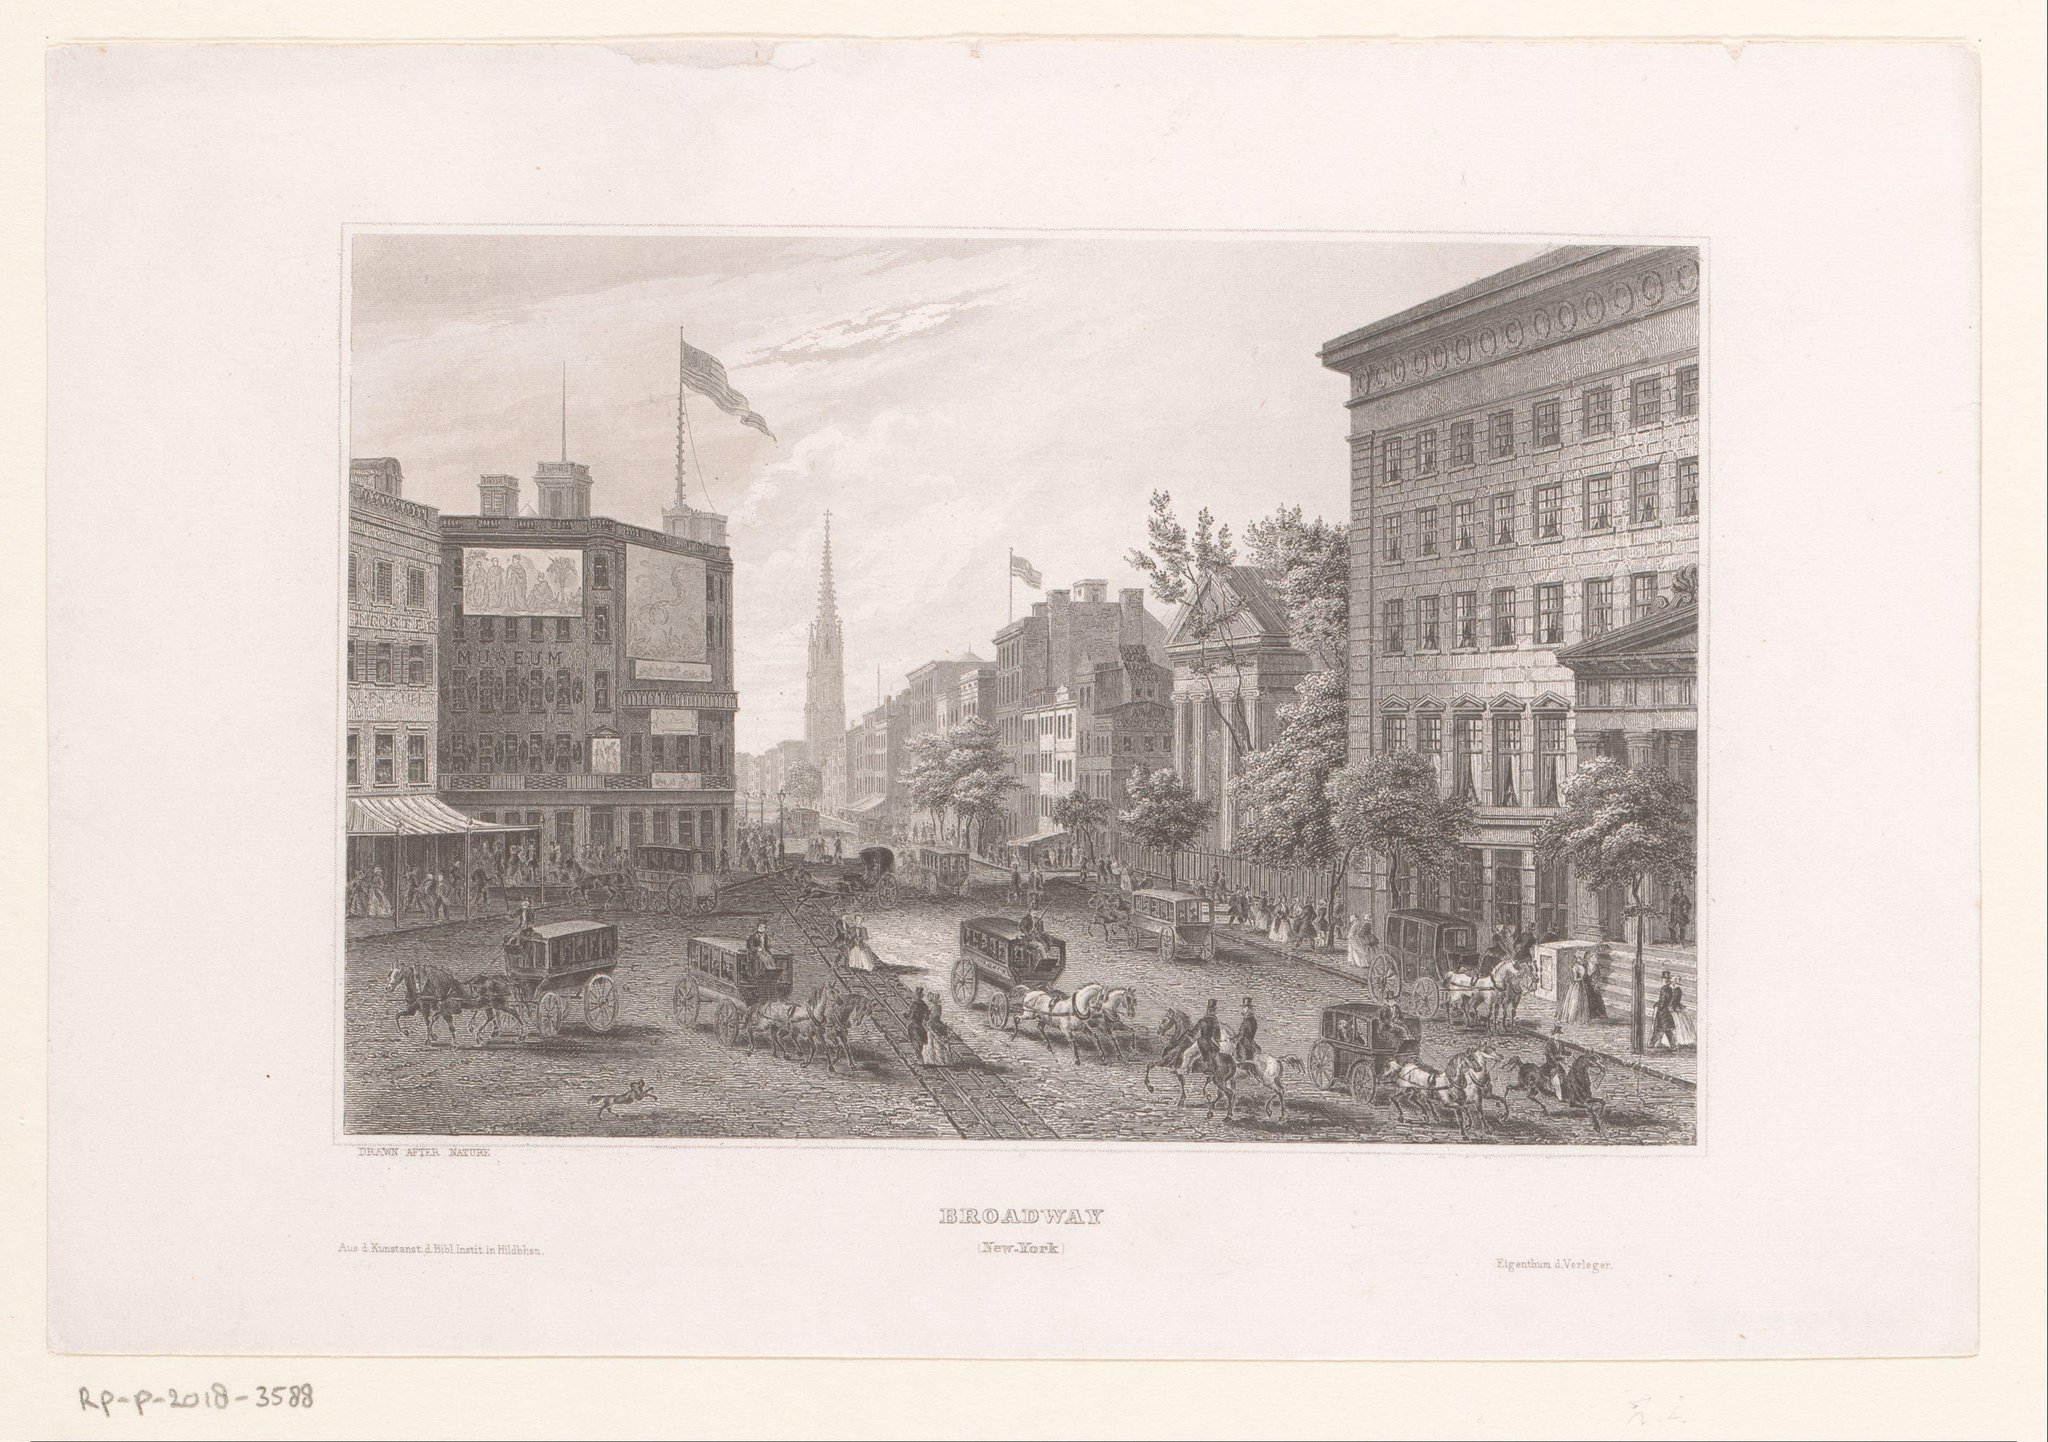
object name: print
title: Gezicht op Broadway, New York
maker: Anonymous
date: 1835-1863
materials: paper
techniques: engraving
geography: hildburghausen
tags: street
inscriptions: collector's mark: Lugt 2228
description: Prent verschenen in: Meyer, Joseph. Meyer's Universum. Hildburghausen: Bibliographisches Institut, 1835-1863.